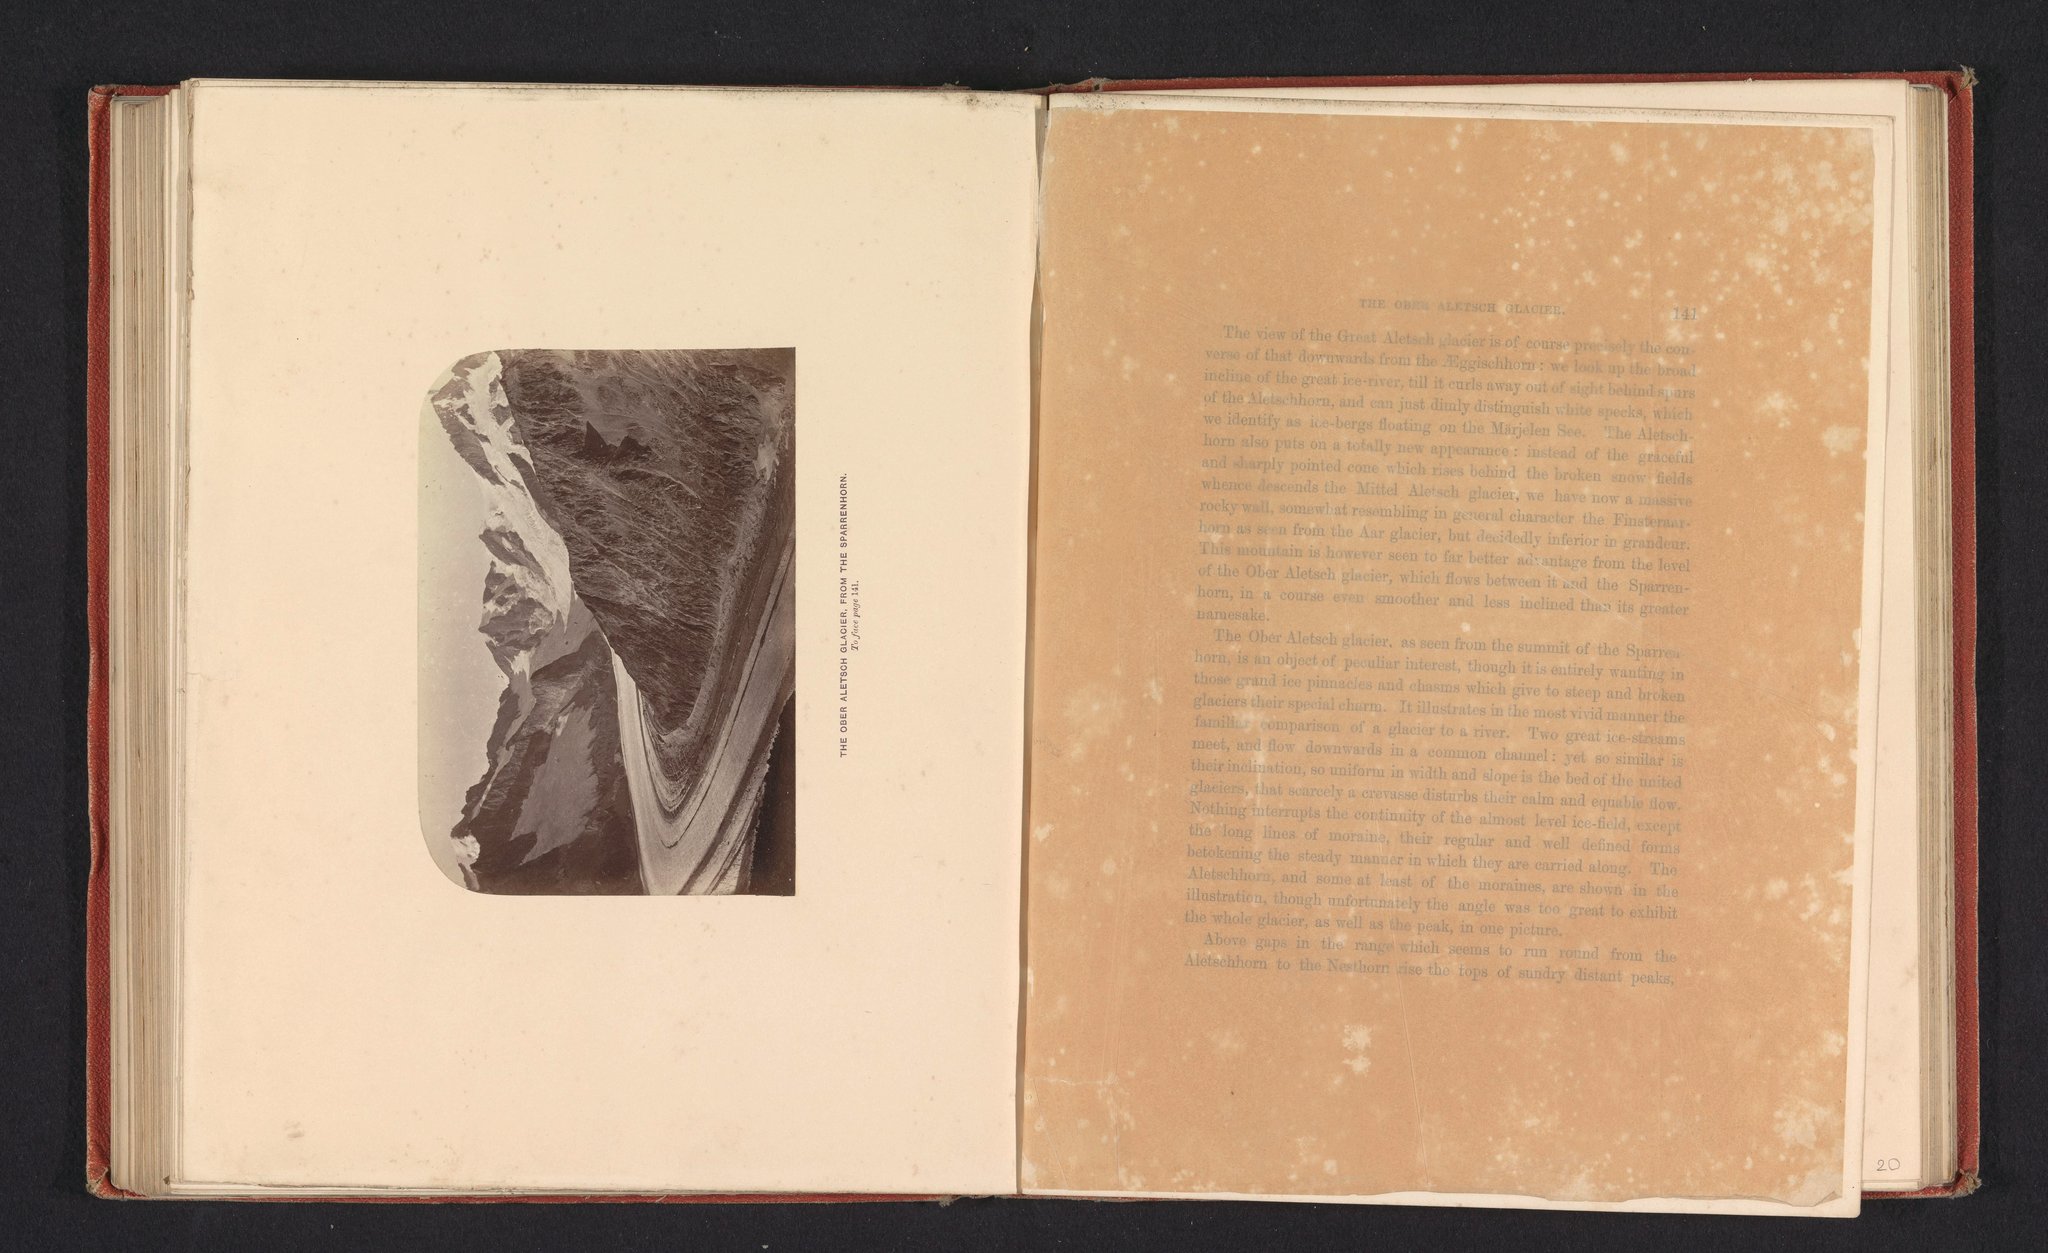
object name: page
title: The Ober Aletsch glacier, from the Sparrenhorn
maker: ernest edwards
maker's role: fotograaf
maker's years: 1837-1903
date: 1850-1866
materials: photographic support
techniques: albumen print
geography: bern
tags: glacier, mountain-range, snow peaks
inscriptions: inscription: ‘To face page 141.’